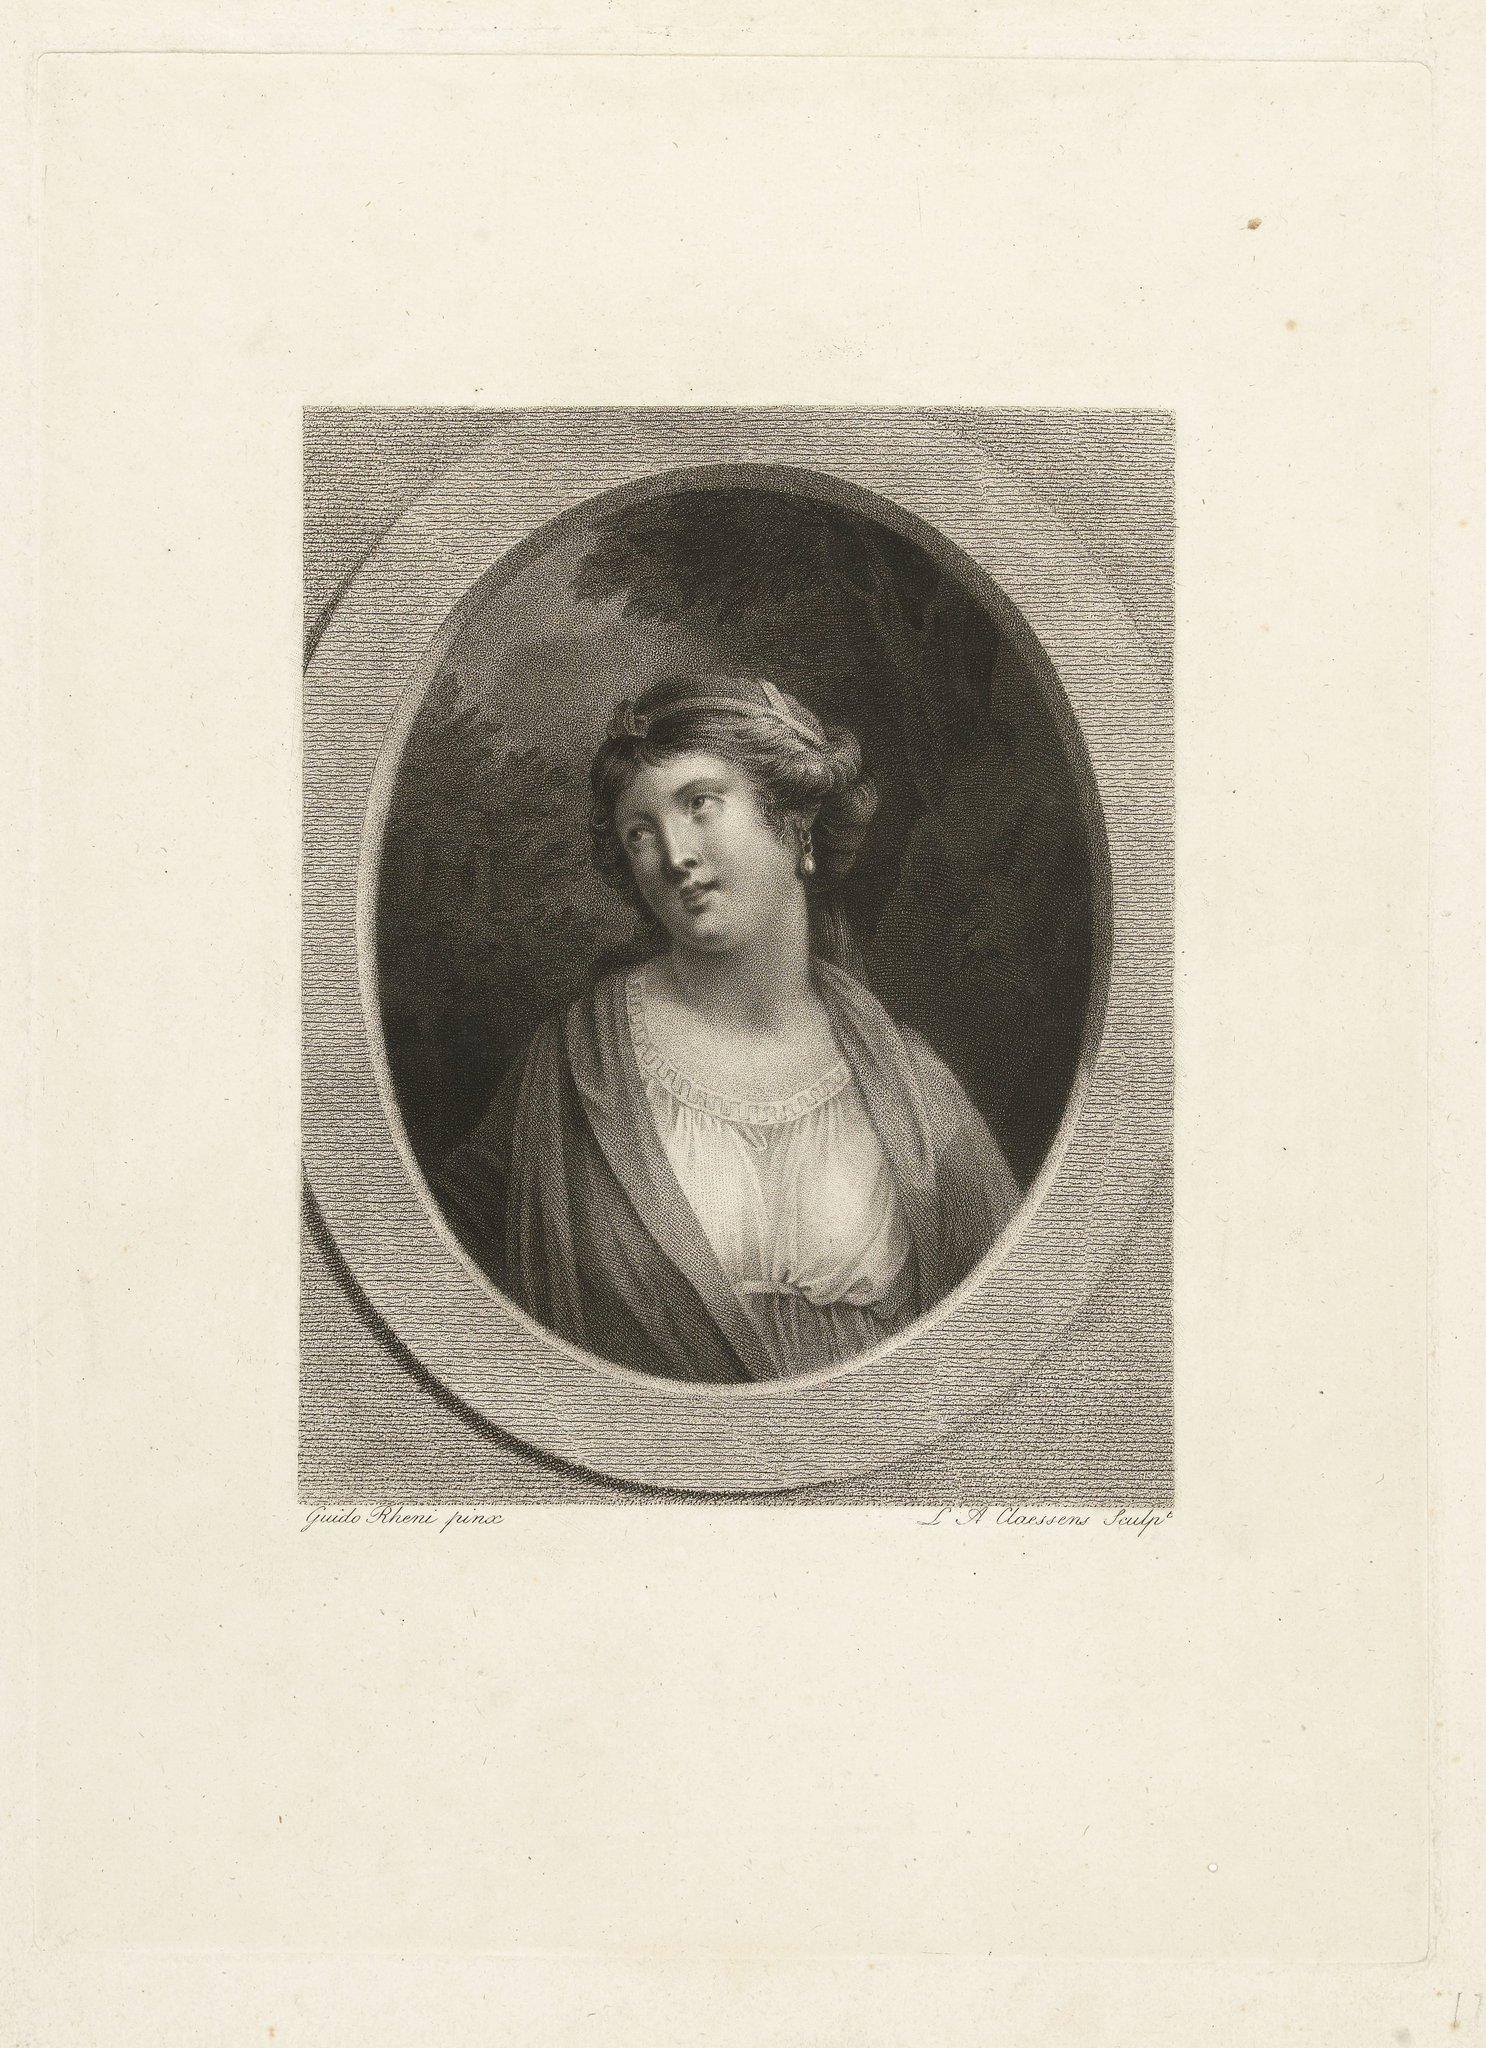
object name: print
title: Portret van een jonge vrouw met haarband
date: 1829-1834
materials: paper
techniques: engraving, etching, roulette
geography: paris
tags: the (nude) human figure; 'corpo humano' (ripa) (+ young female (human being))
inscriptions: collector's mark: Lugt 2228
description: Mogelijk gemaakt voor: Musée français : recueil des plus beaux tableaux, statues et bas-reliefs qui existaient au Louvre avant 1815, avec l'explication des sujets, et des discours historiques sur la peinture, la sculpture et la gravure. Paris: A. & W. Galignani & Londers, J.O. Robinson, [1829-39]